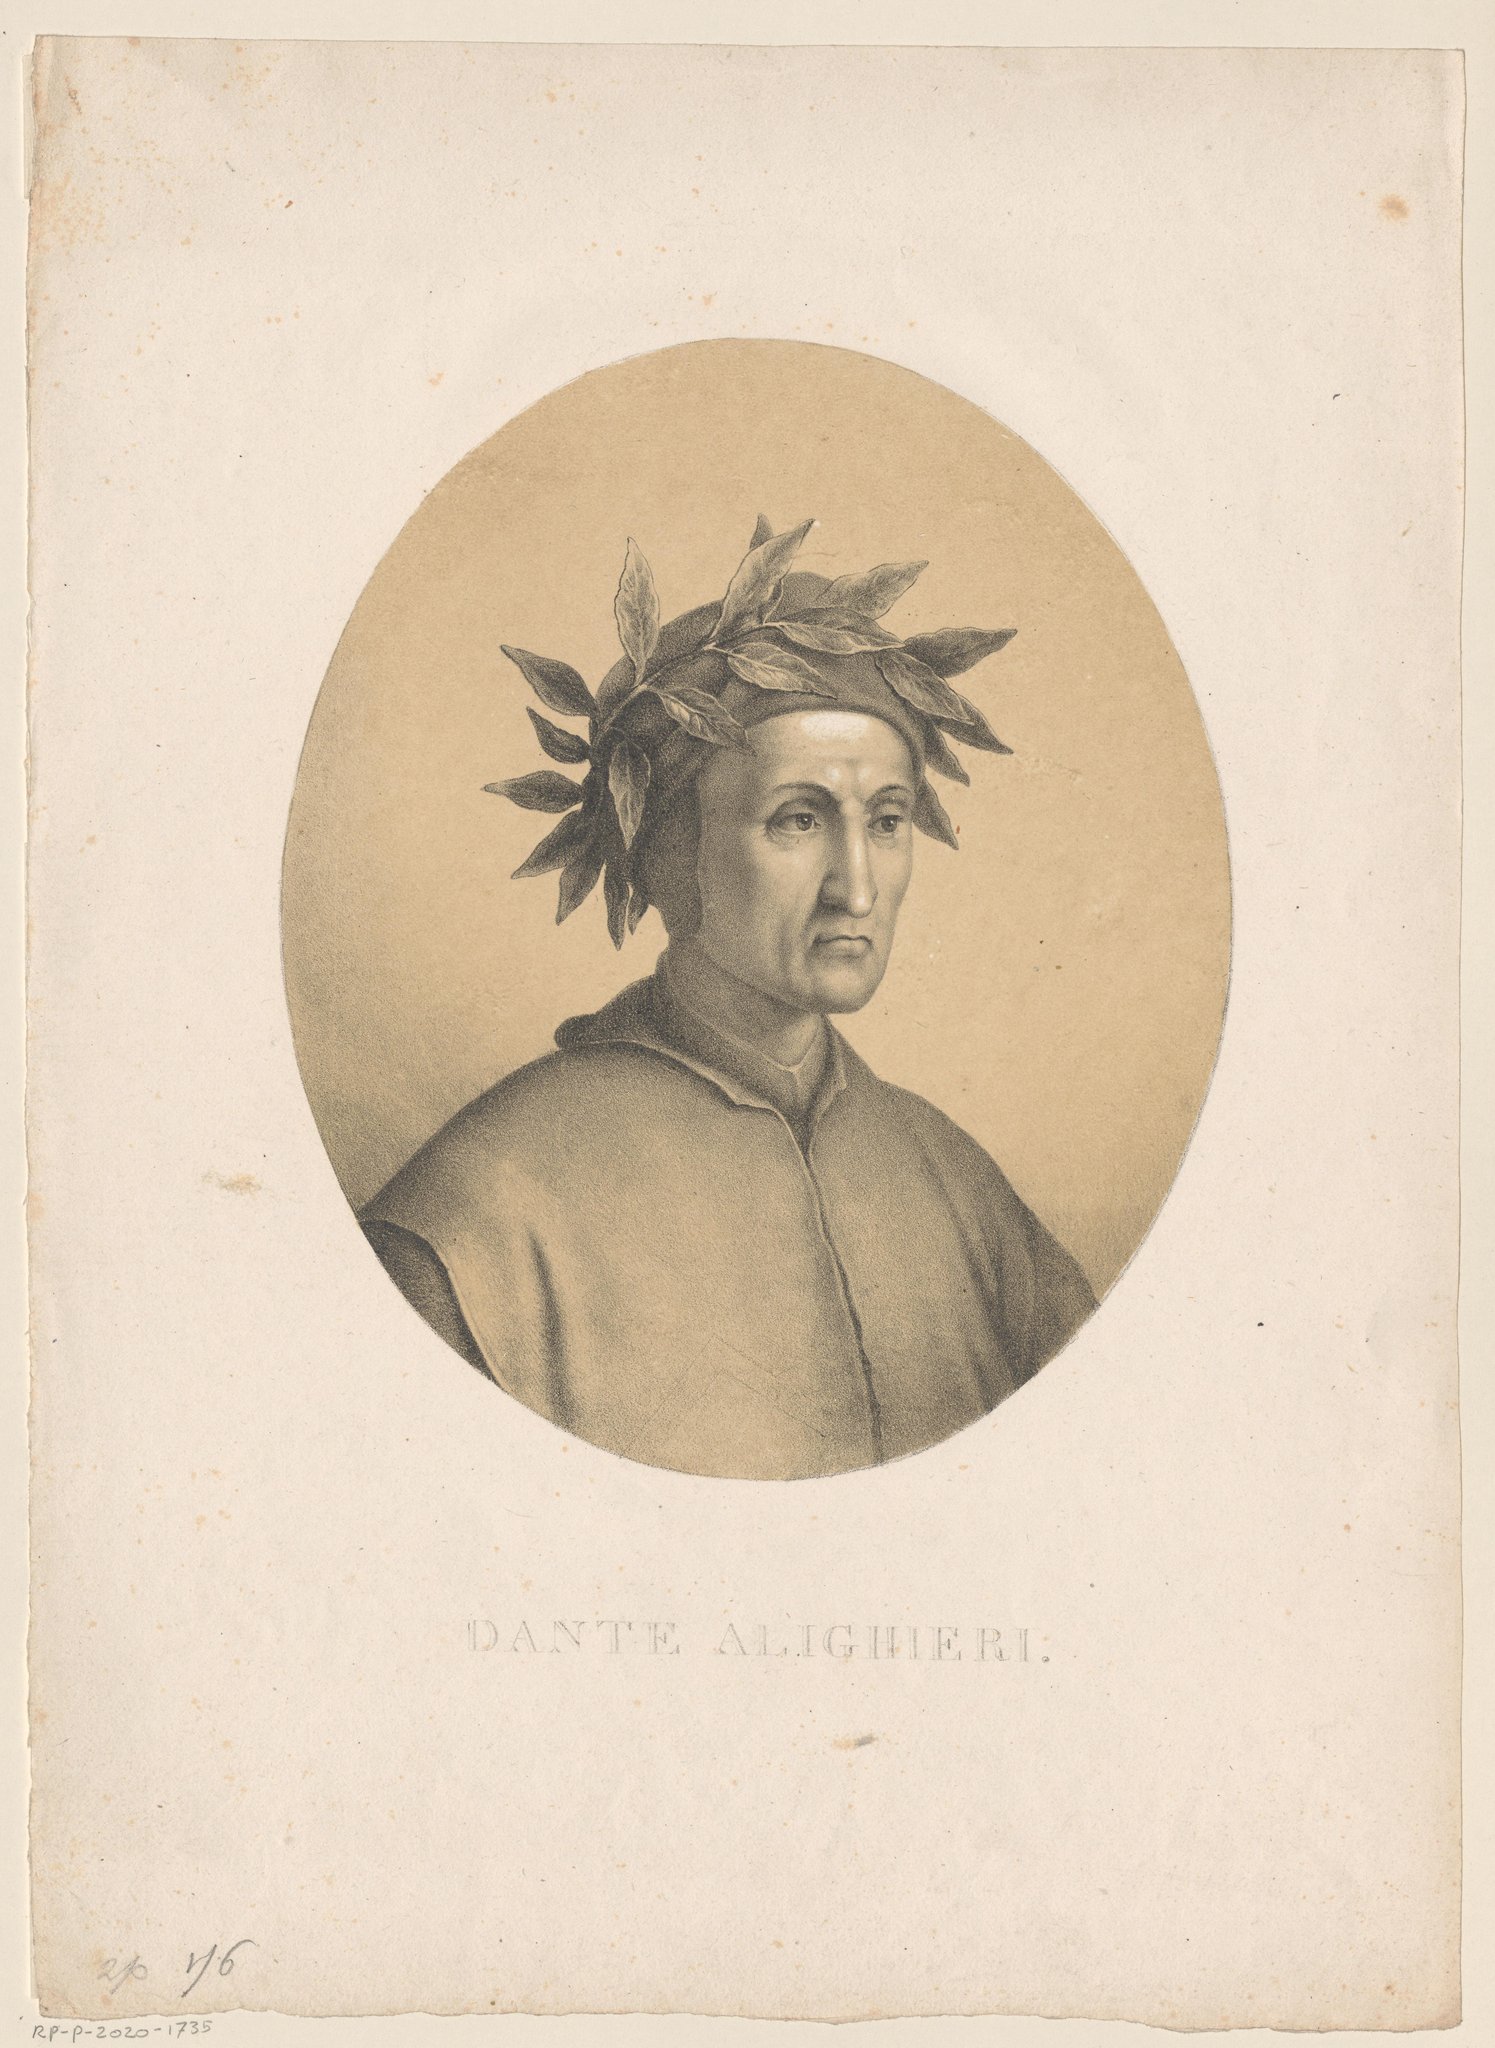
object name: print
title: Portret van Dante Alighieri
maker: Anonymous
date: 1800-1899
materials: paper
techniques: tone lithography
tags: dante alighieri, historical persons, portrait of a writer, writer, poet, author